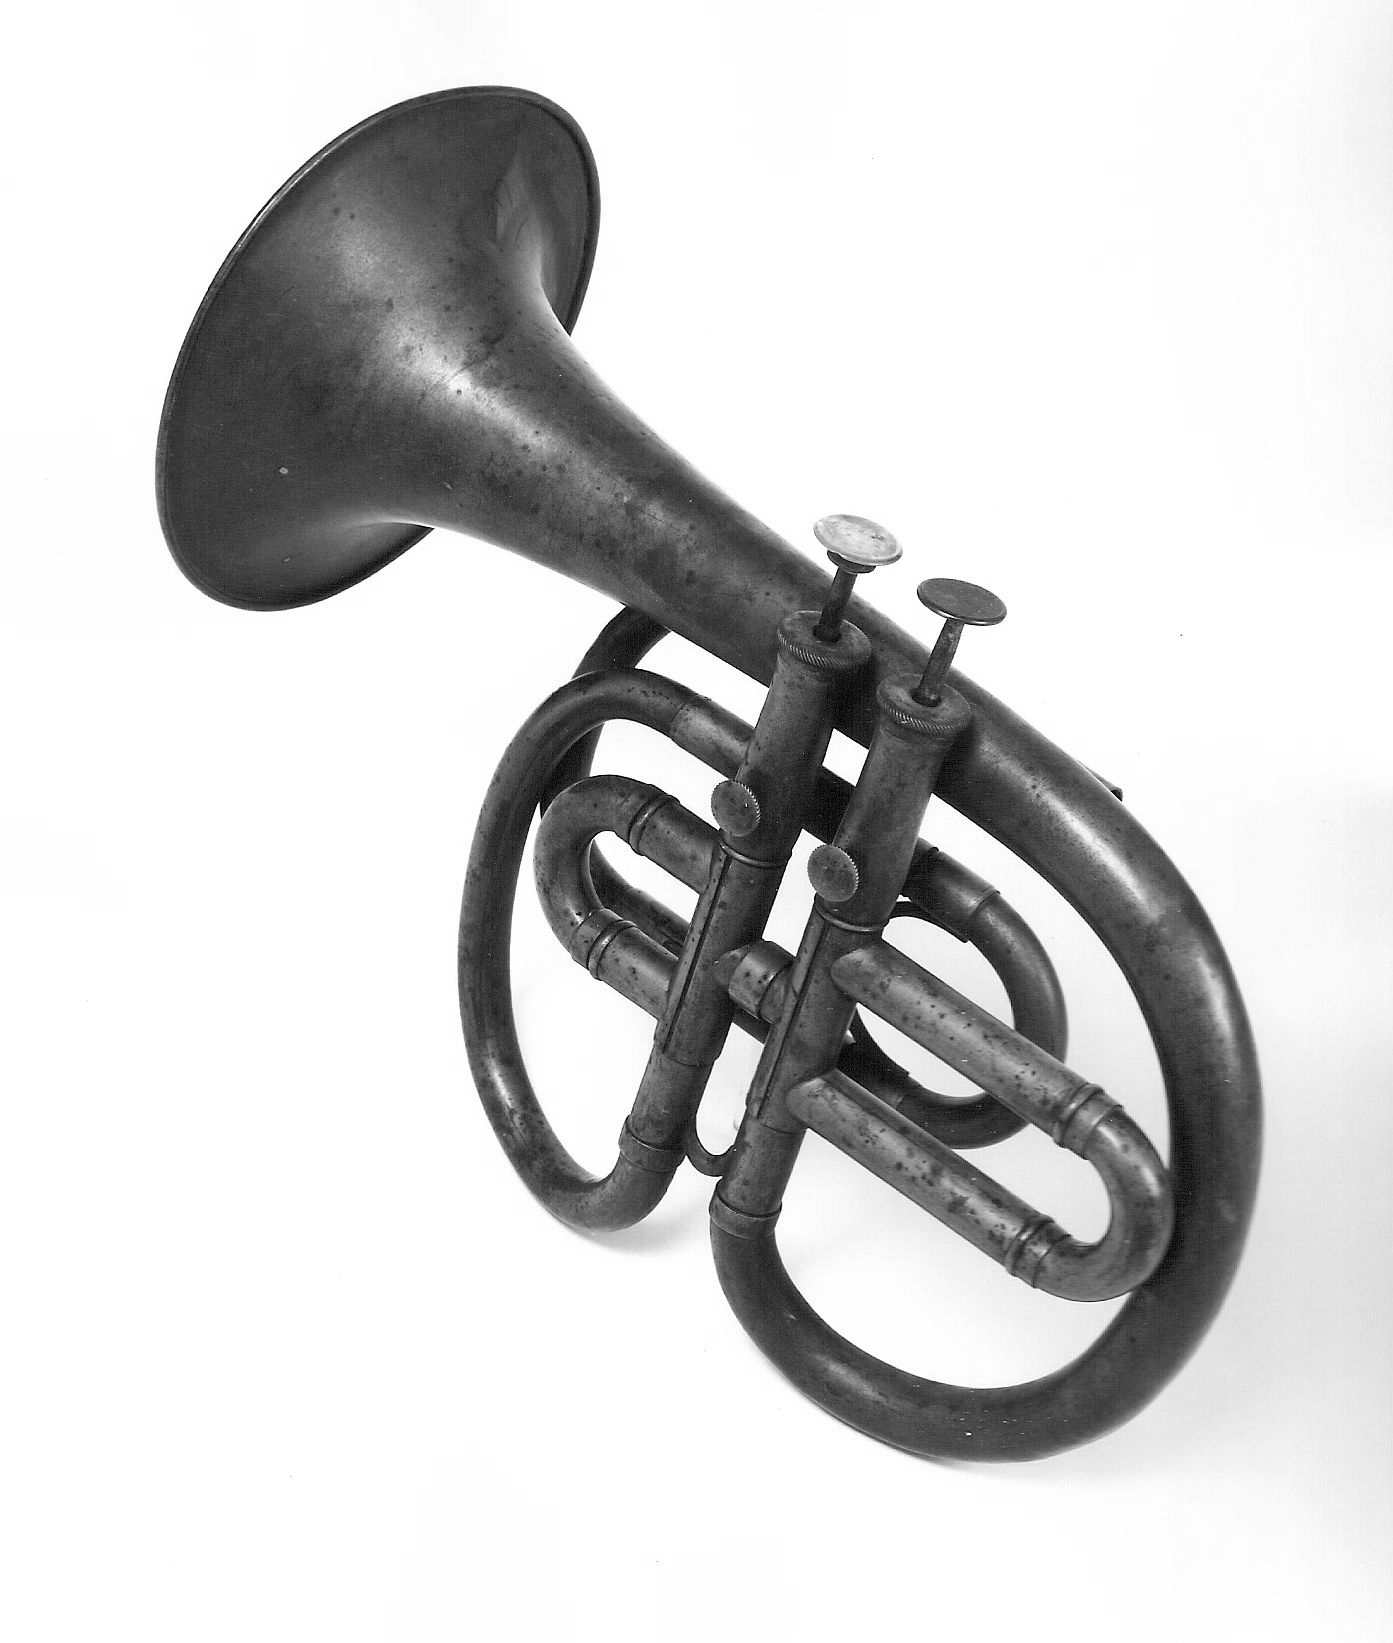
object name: cornopean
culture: british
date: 1835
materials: brass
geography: united kingdom